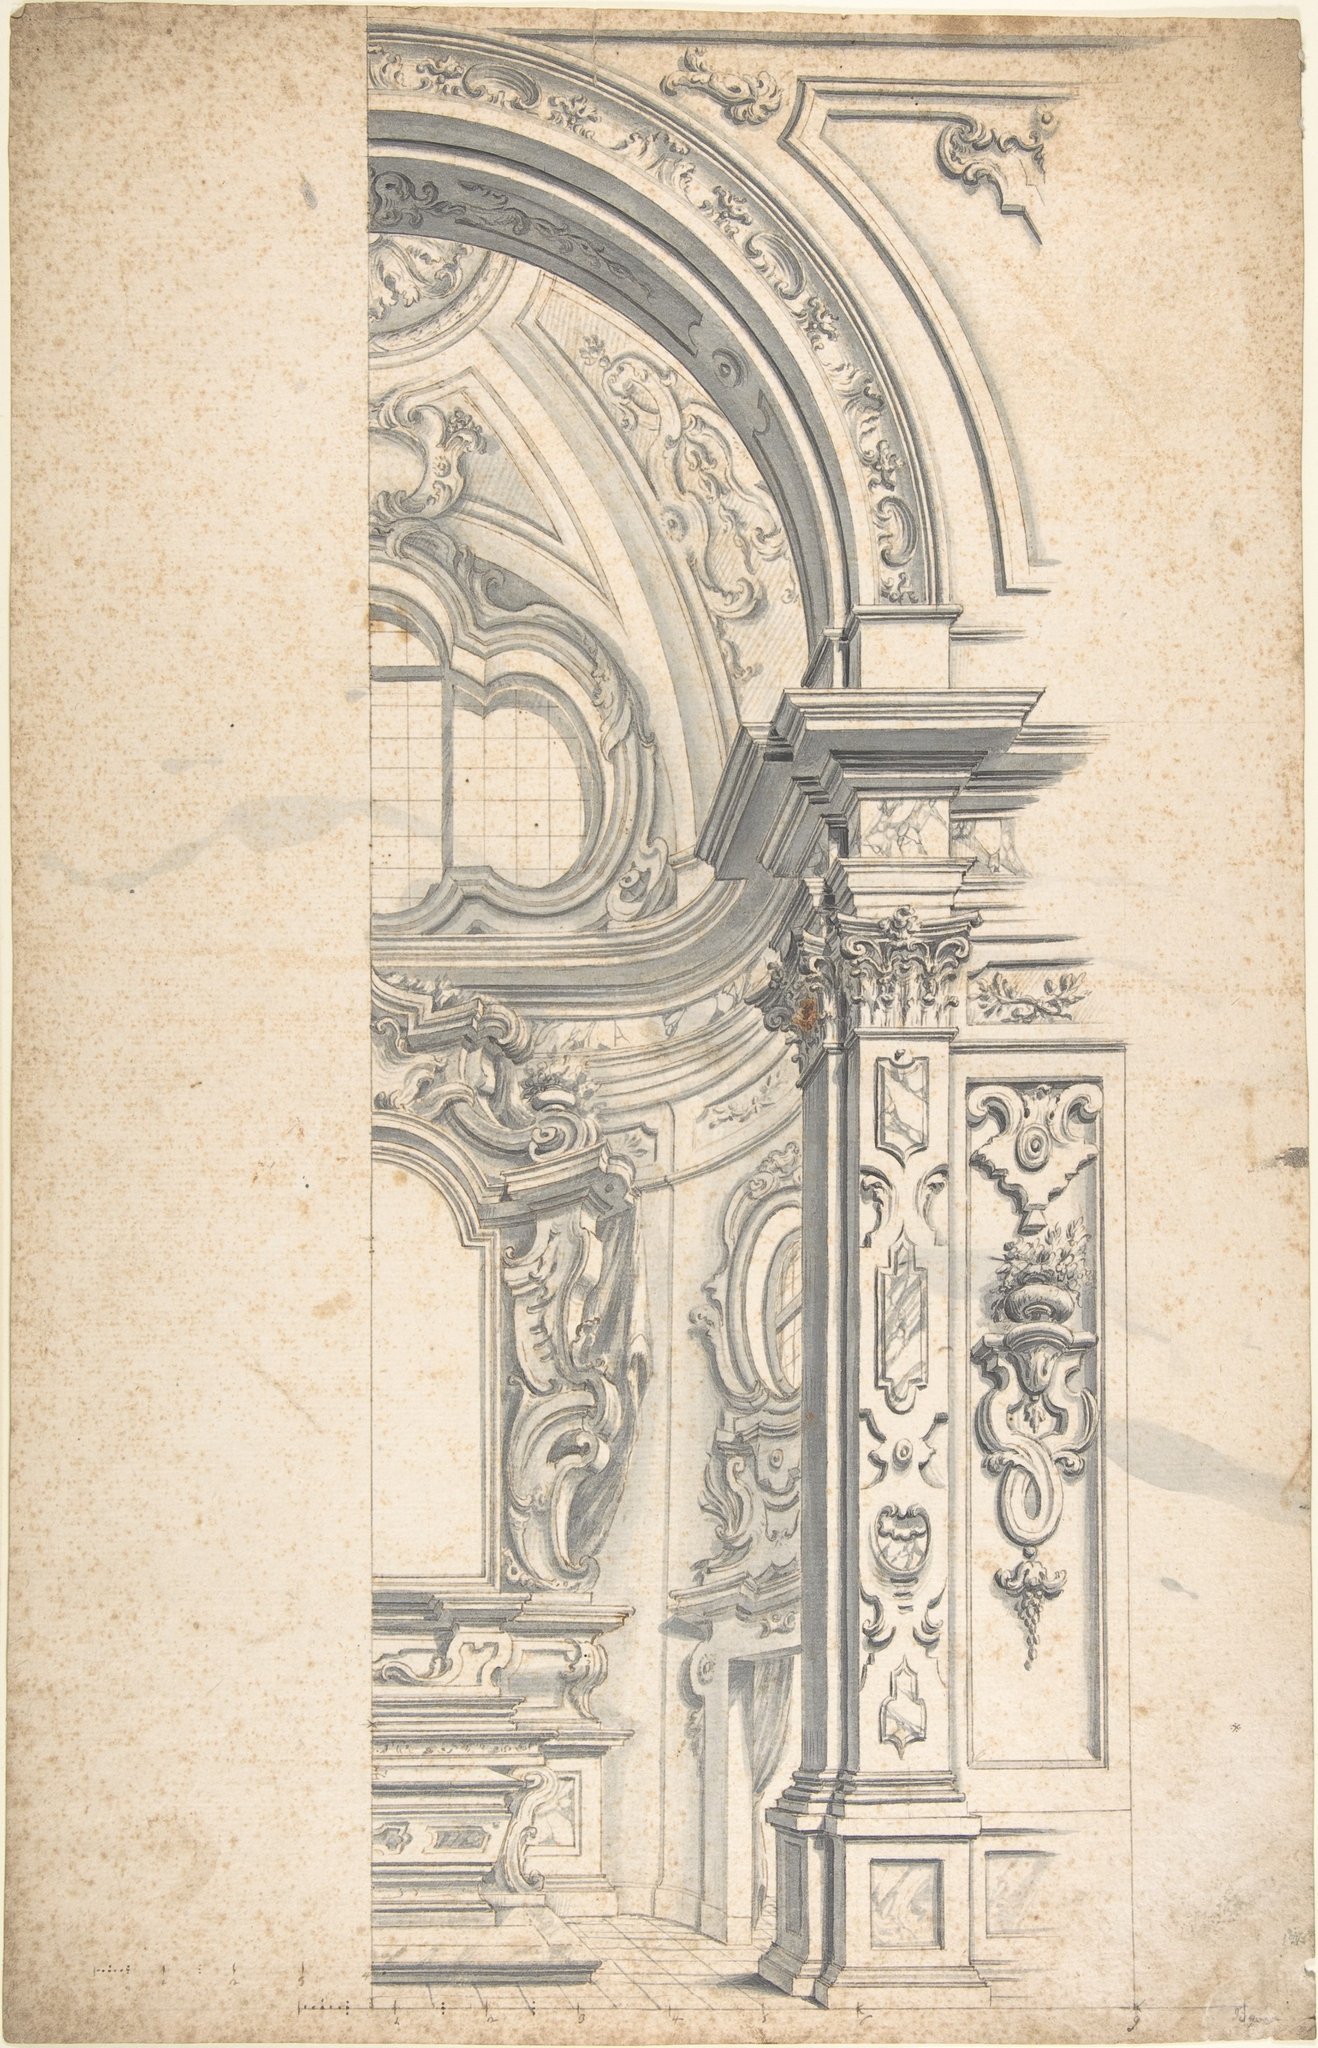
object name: drawing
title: Project for a Chapel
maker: anonymous, italian, piedmontese, 18th century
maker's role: artist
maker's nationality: italian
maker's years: 1700-1800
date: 1700-1780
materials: ink, drawing material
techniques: brush, drawing, pen, wash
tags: architecture,chapels